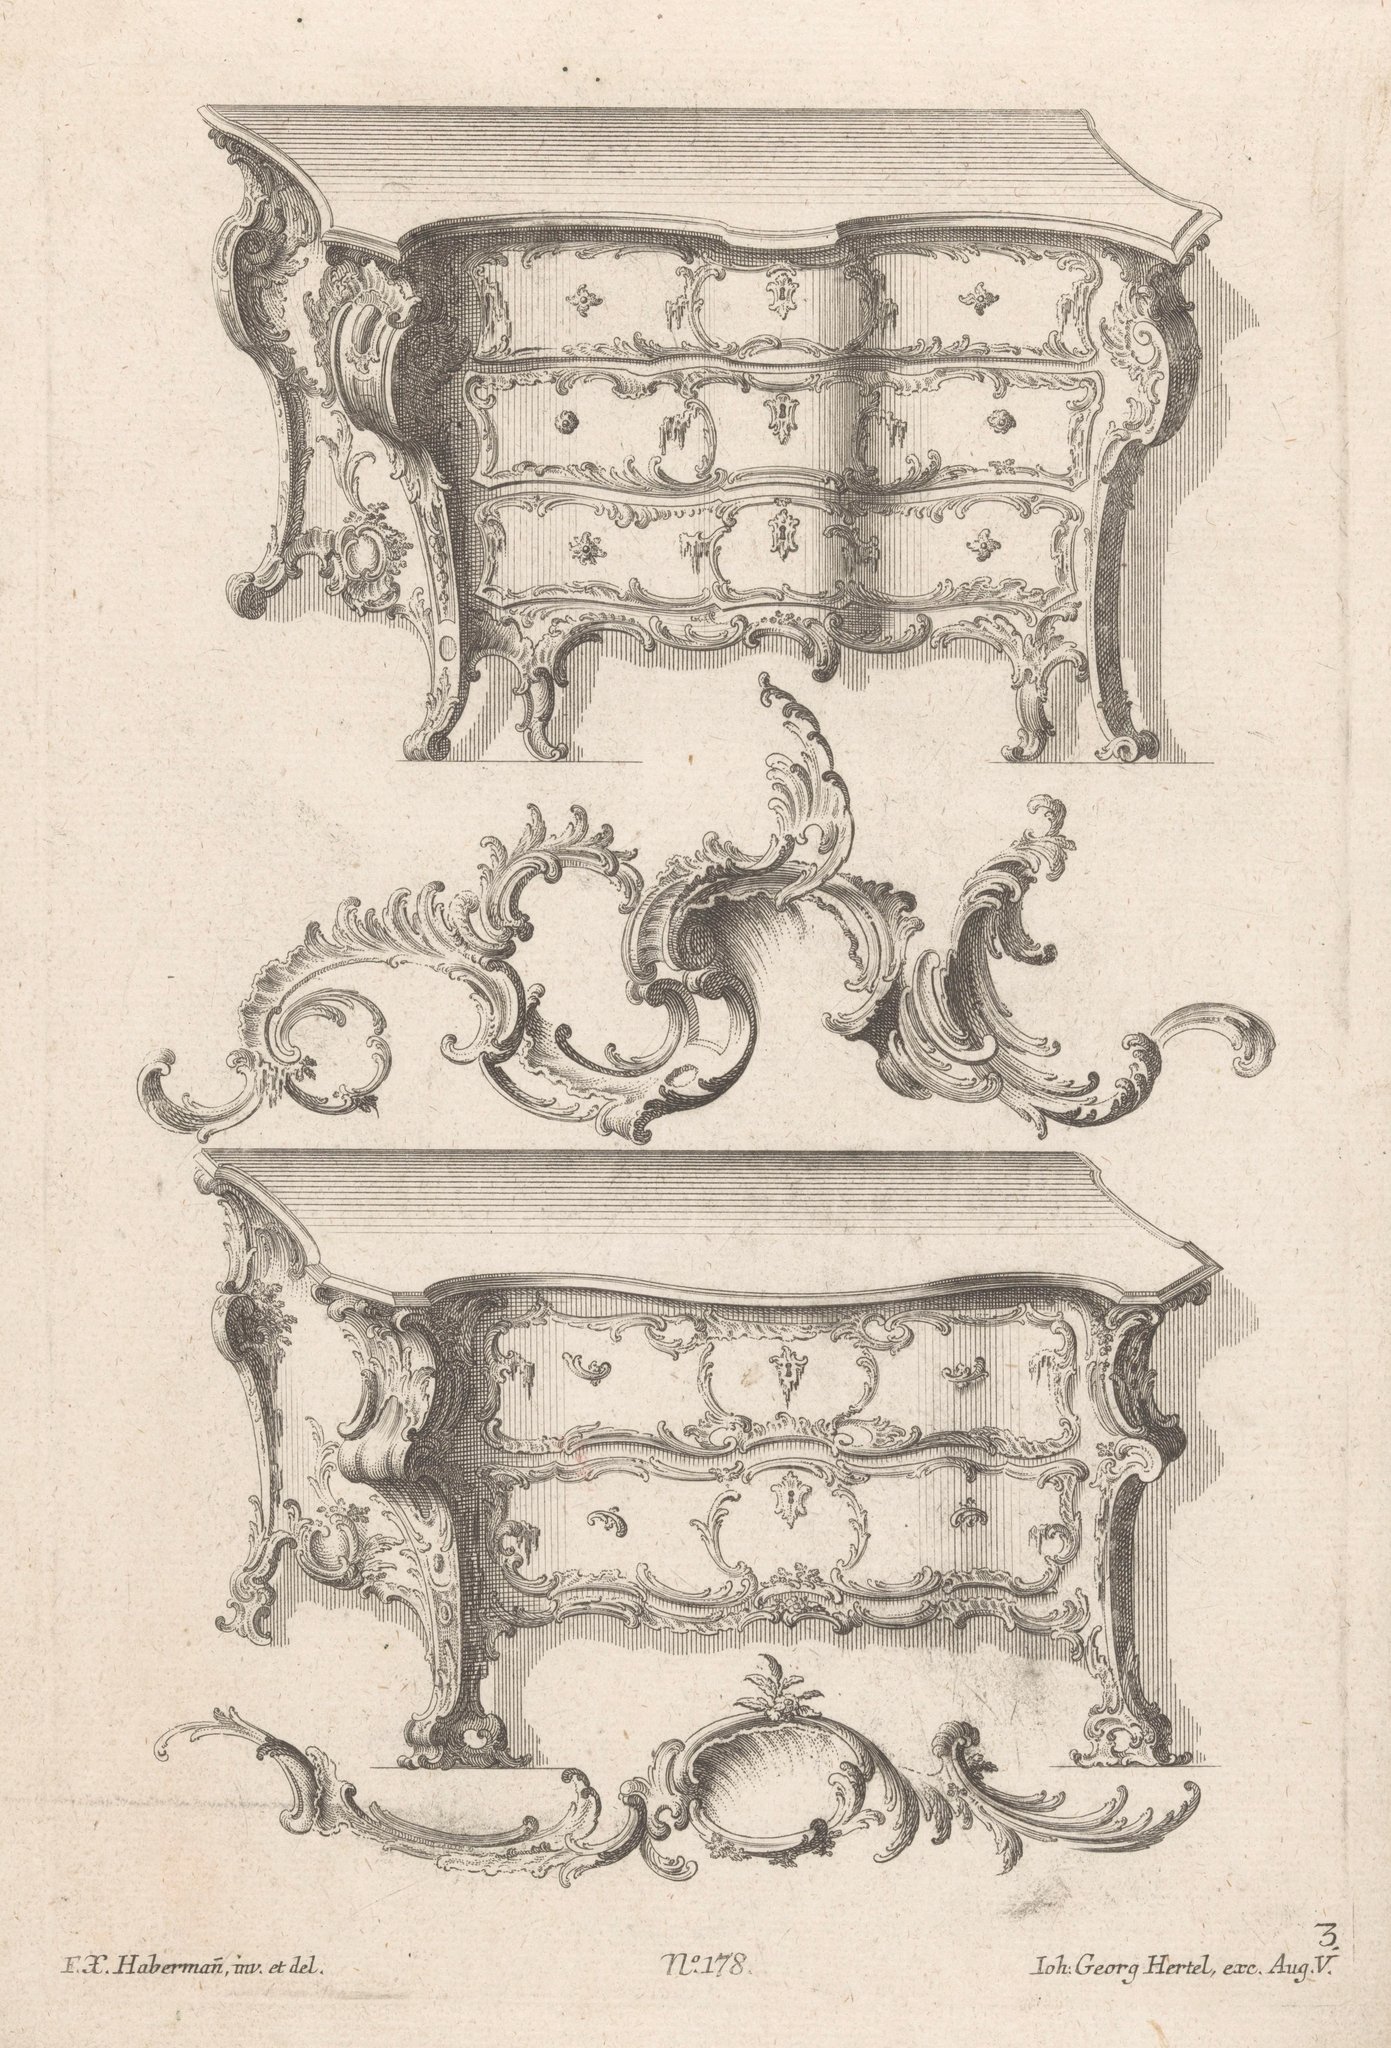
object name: print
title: Commodes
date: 1731-1775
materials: paper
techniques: engraving, etching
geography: augsburg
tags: ornamental cupboard, rocaille ornament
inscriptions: collector's mark: Lugt 2228, collector's mark: Lugt 2760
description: Een commode met drie lades en een commode met twee lades, met rocaille ornamenten. Uitgeversnummer 178.